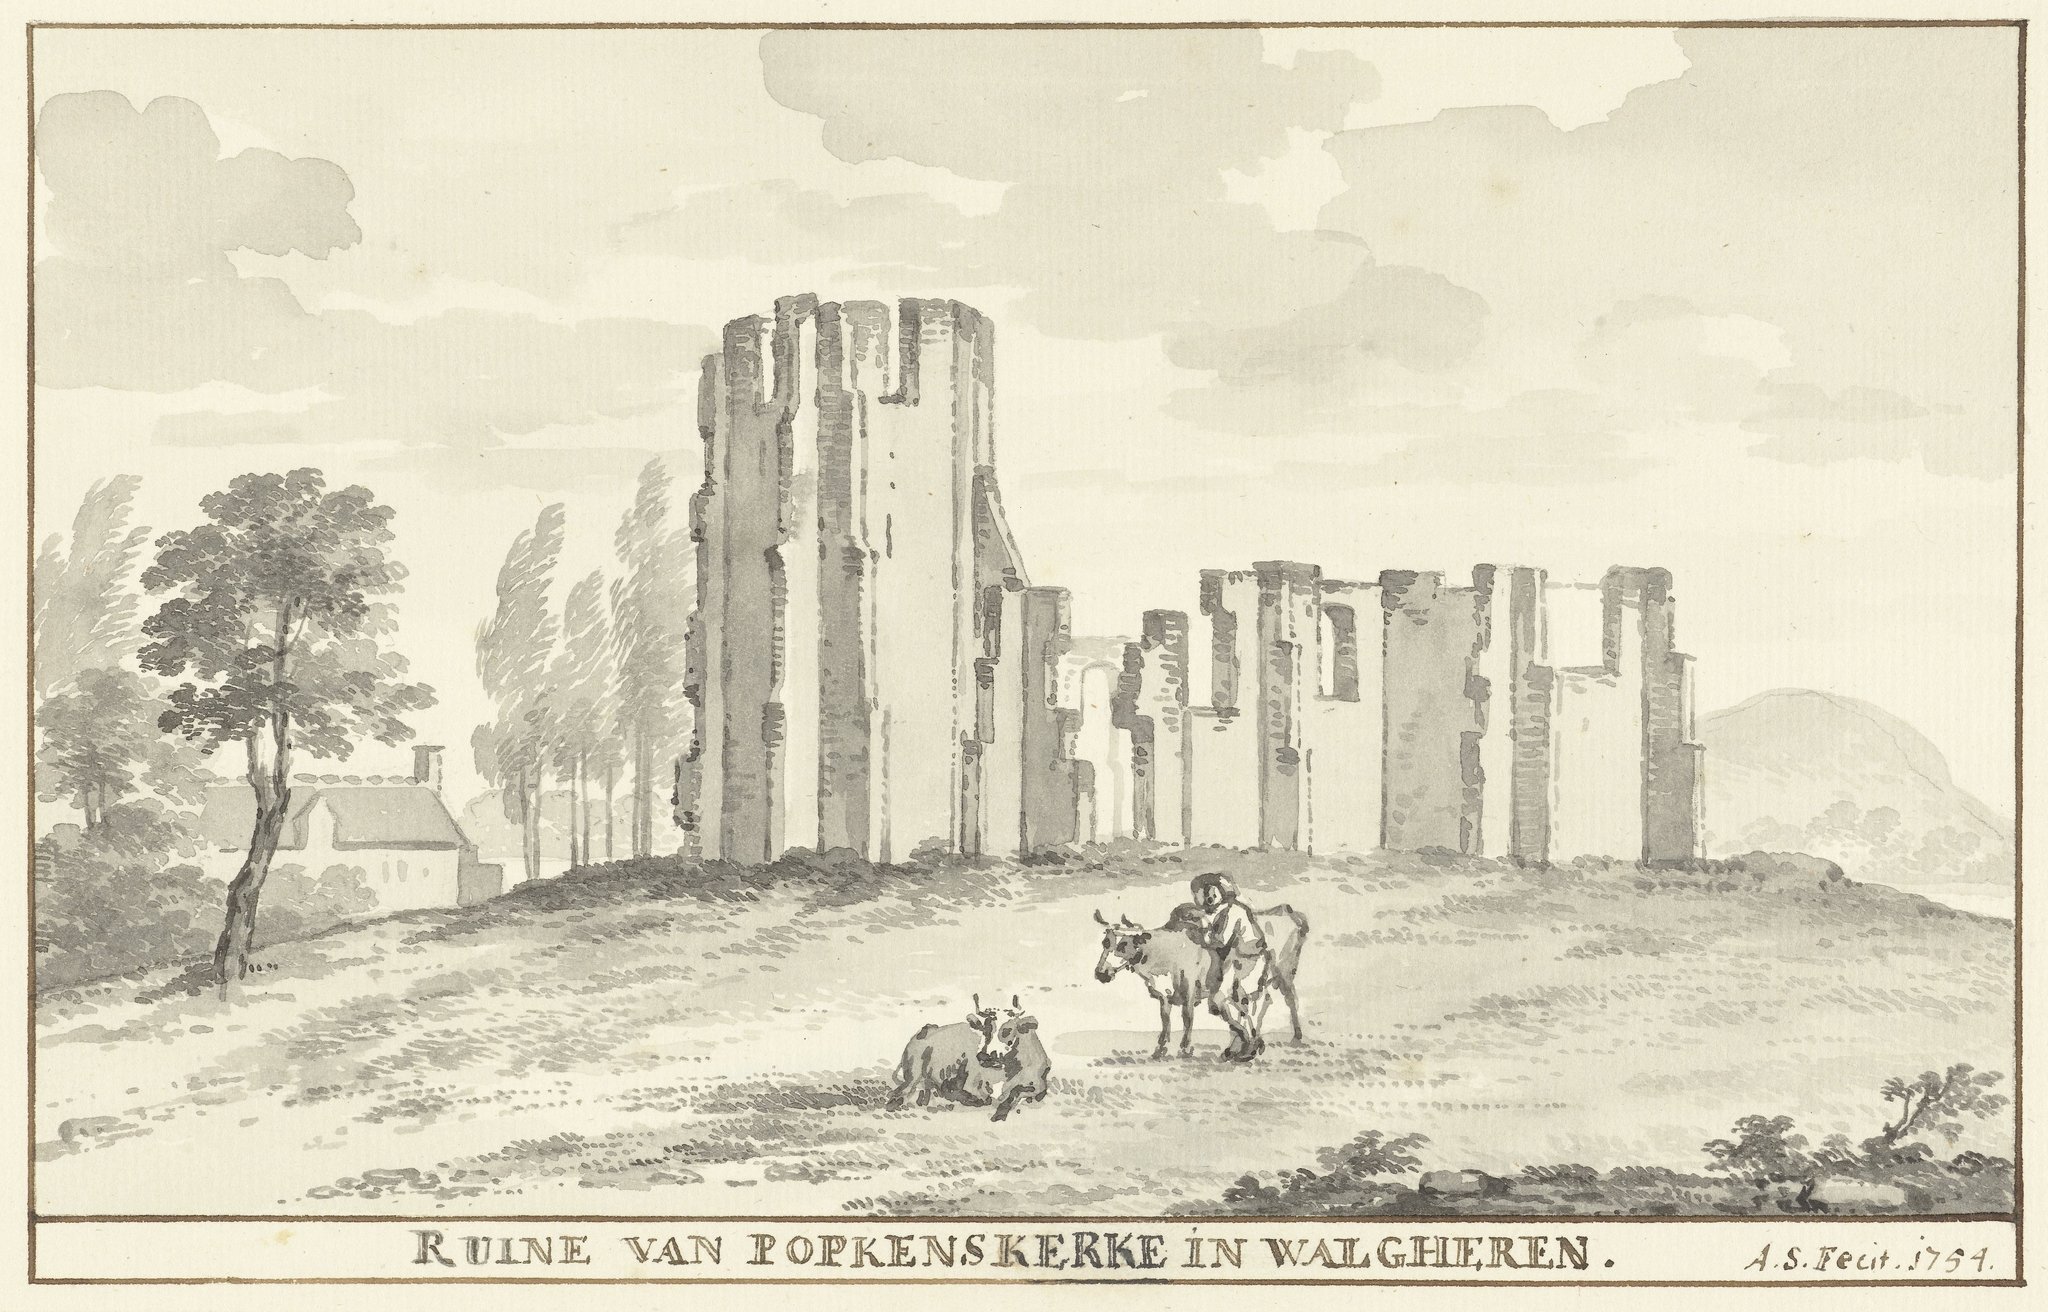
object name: drawing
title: Ruïne te Popkenskerke of Poppekerke te Walcheren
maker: aert schouman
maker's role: draughtsman, painter, print maker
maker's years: 1710-1792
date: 1754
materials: ink, paper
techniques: brush, pen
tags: ruin of a building ~ architecture, ruin of church, monastery, etc.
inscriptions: date